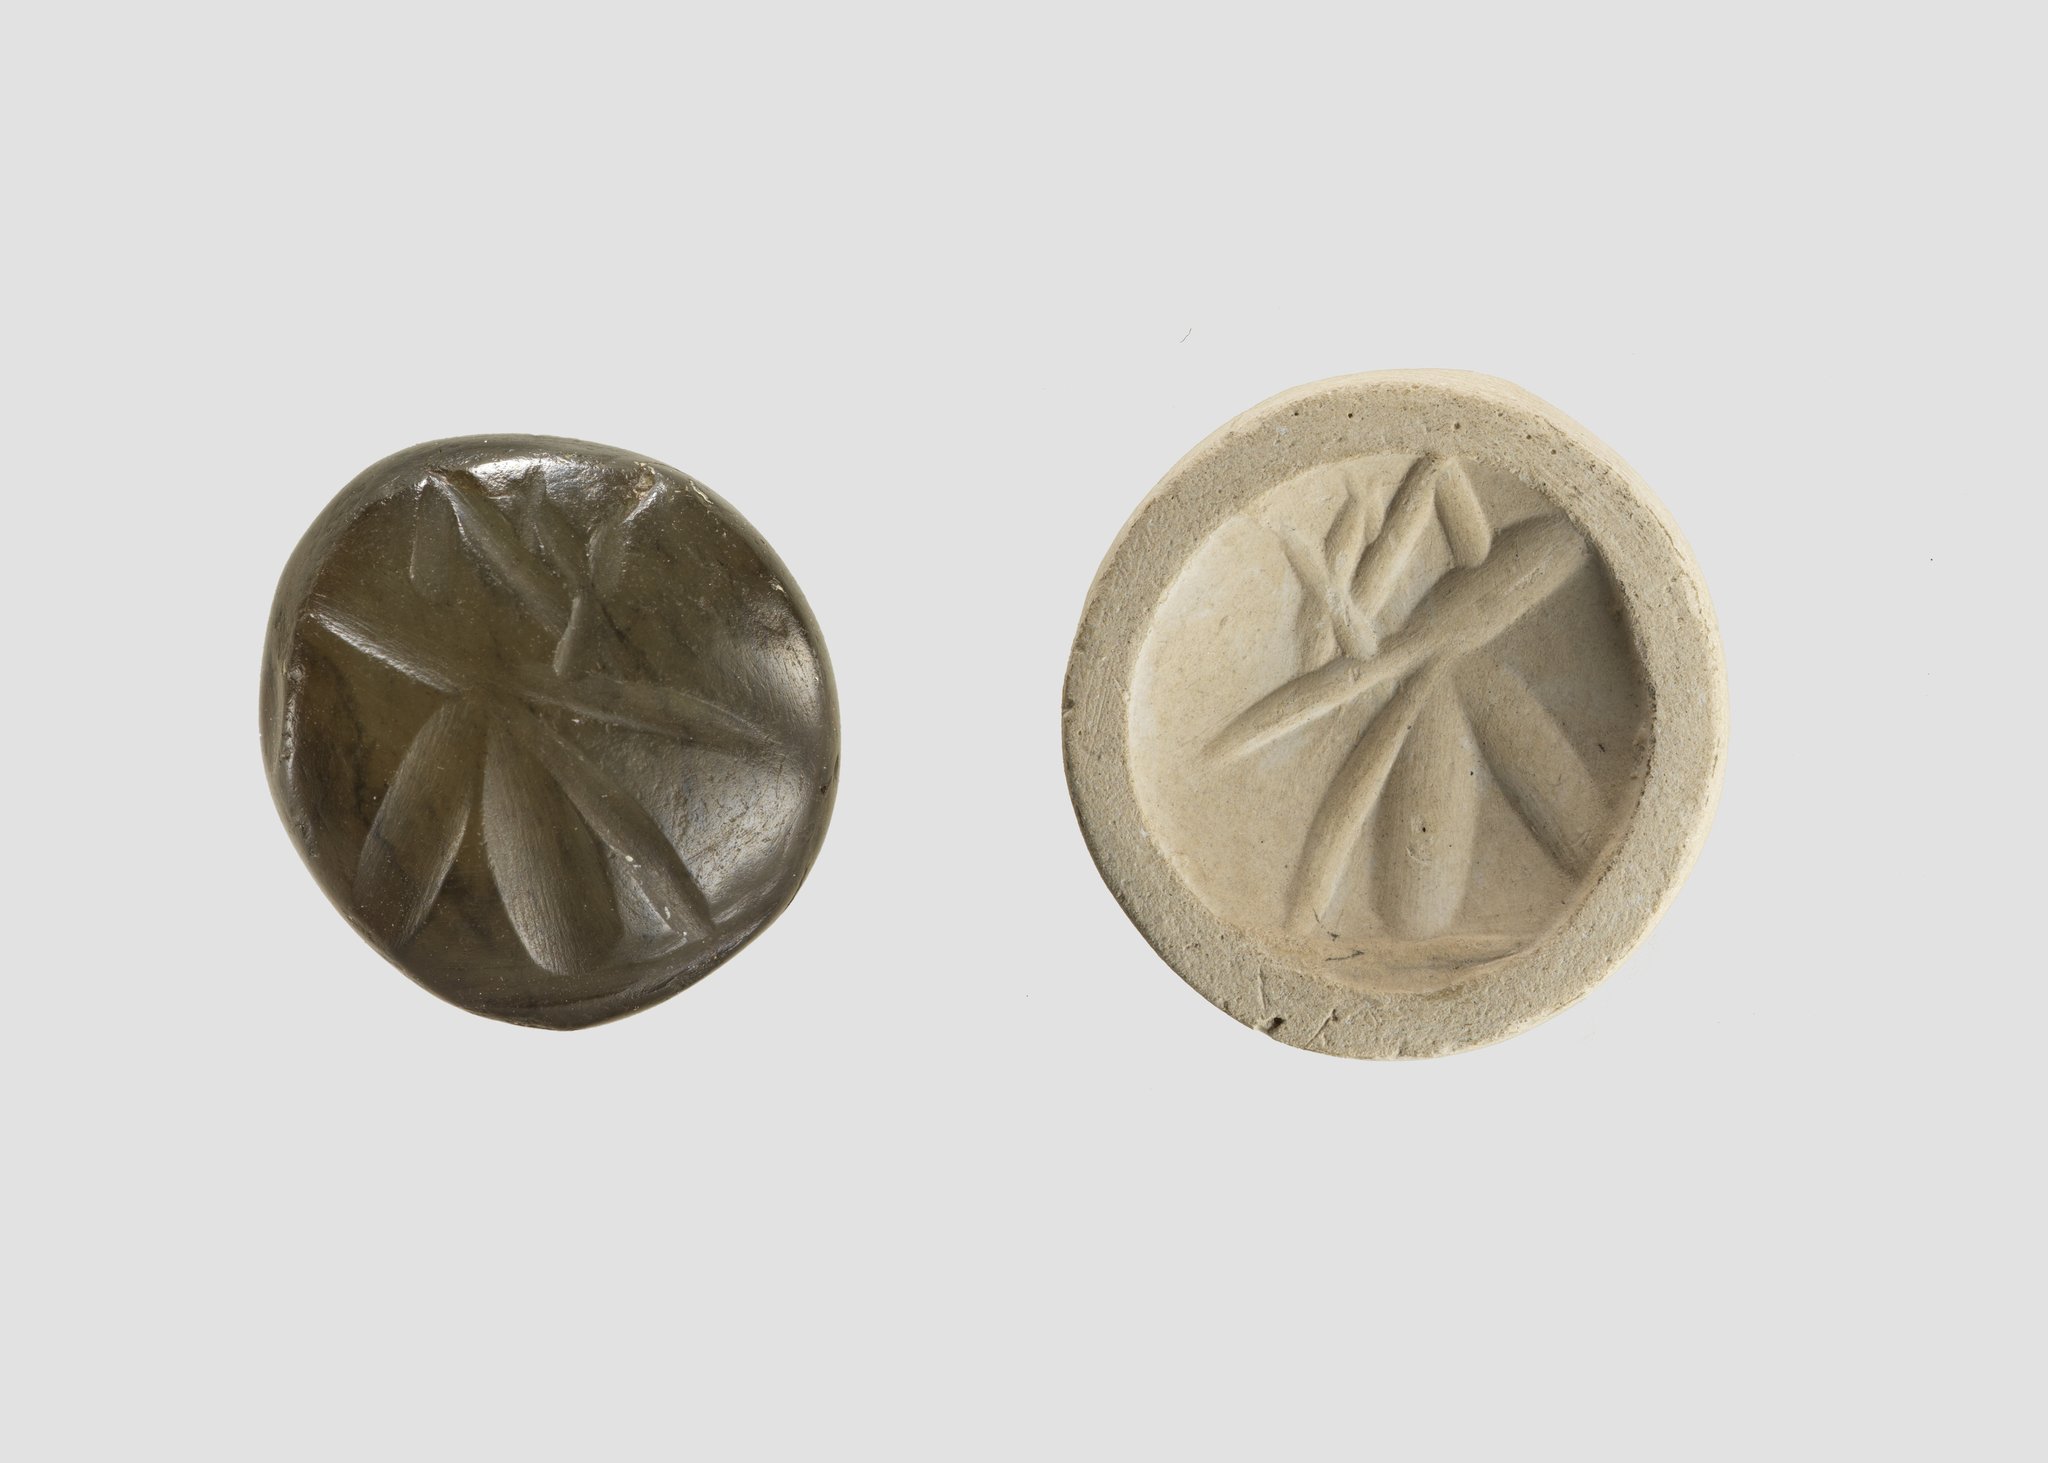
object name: stamp seal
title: Stamp seal (conoid) with divine being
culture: assyro-babylonian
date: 700-501 BCE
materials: stone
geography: mesopotamia